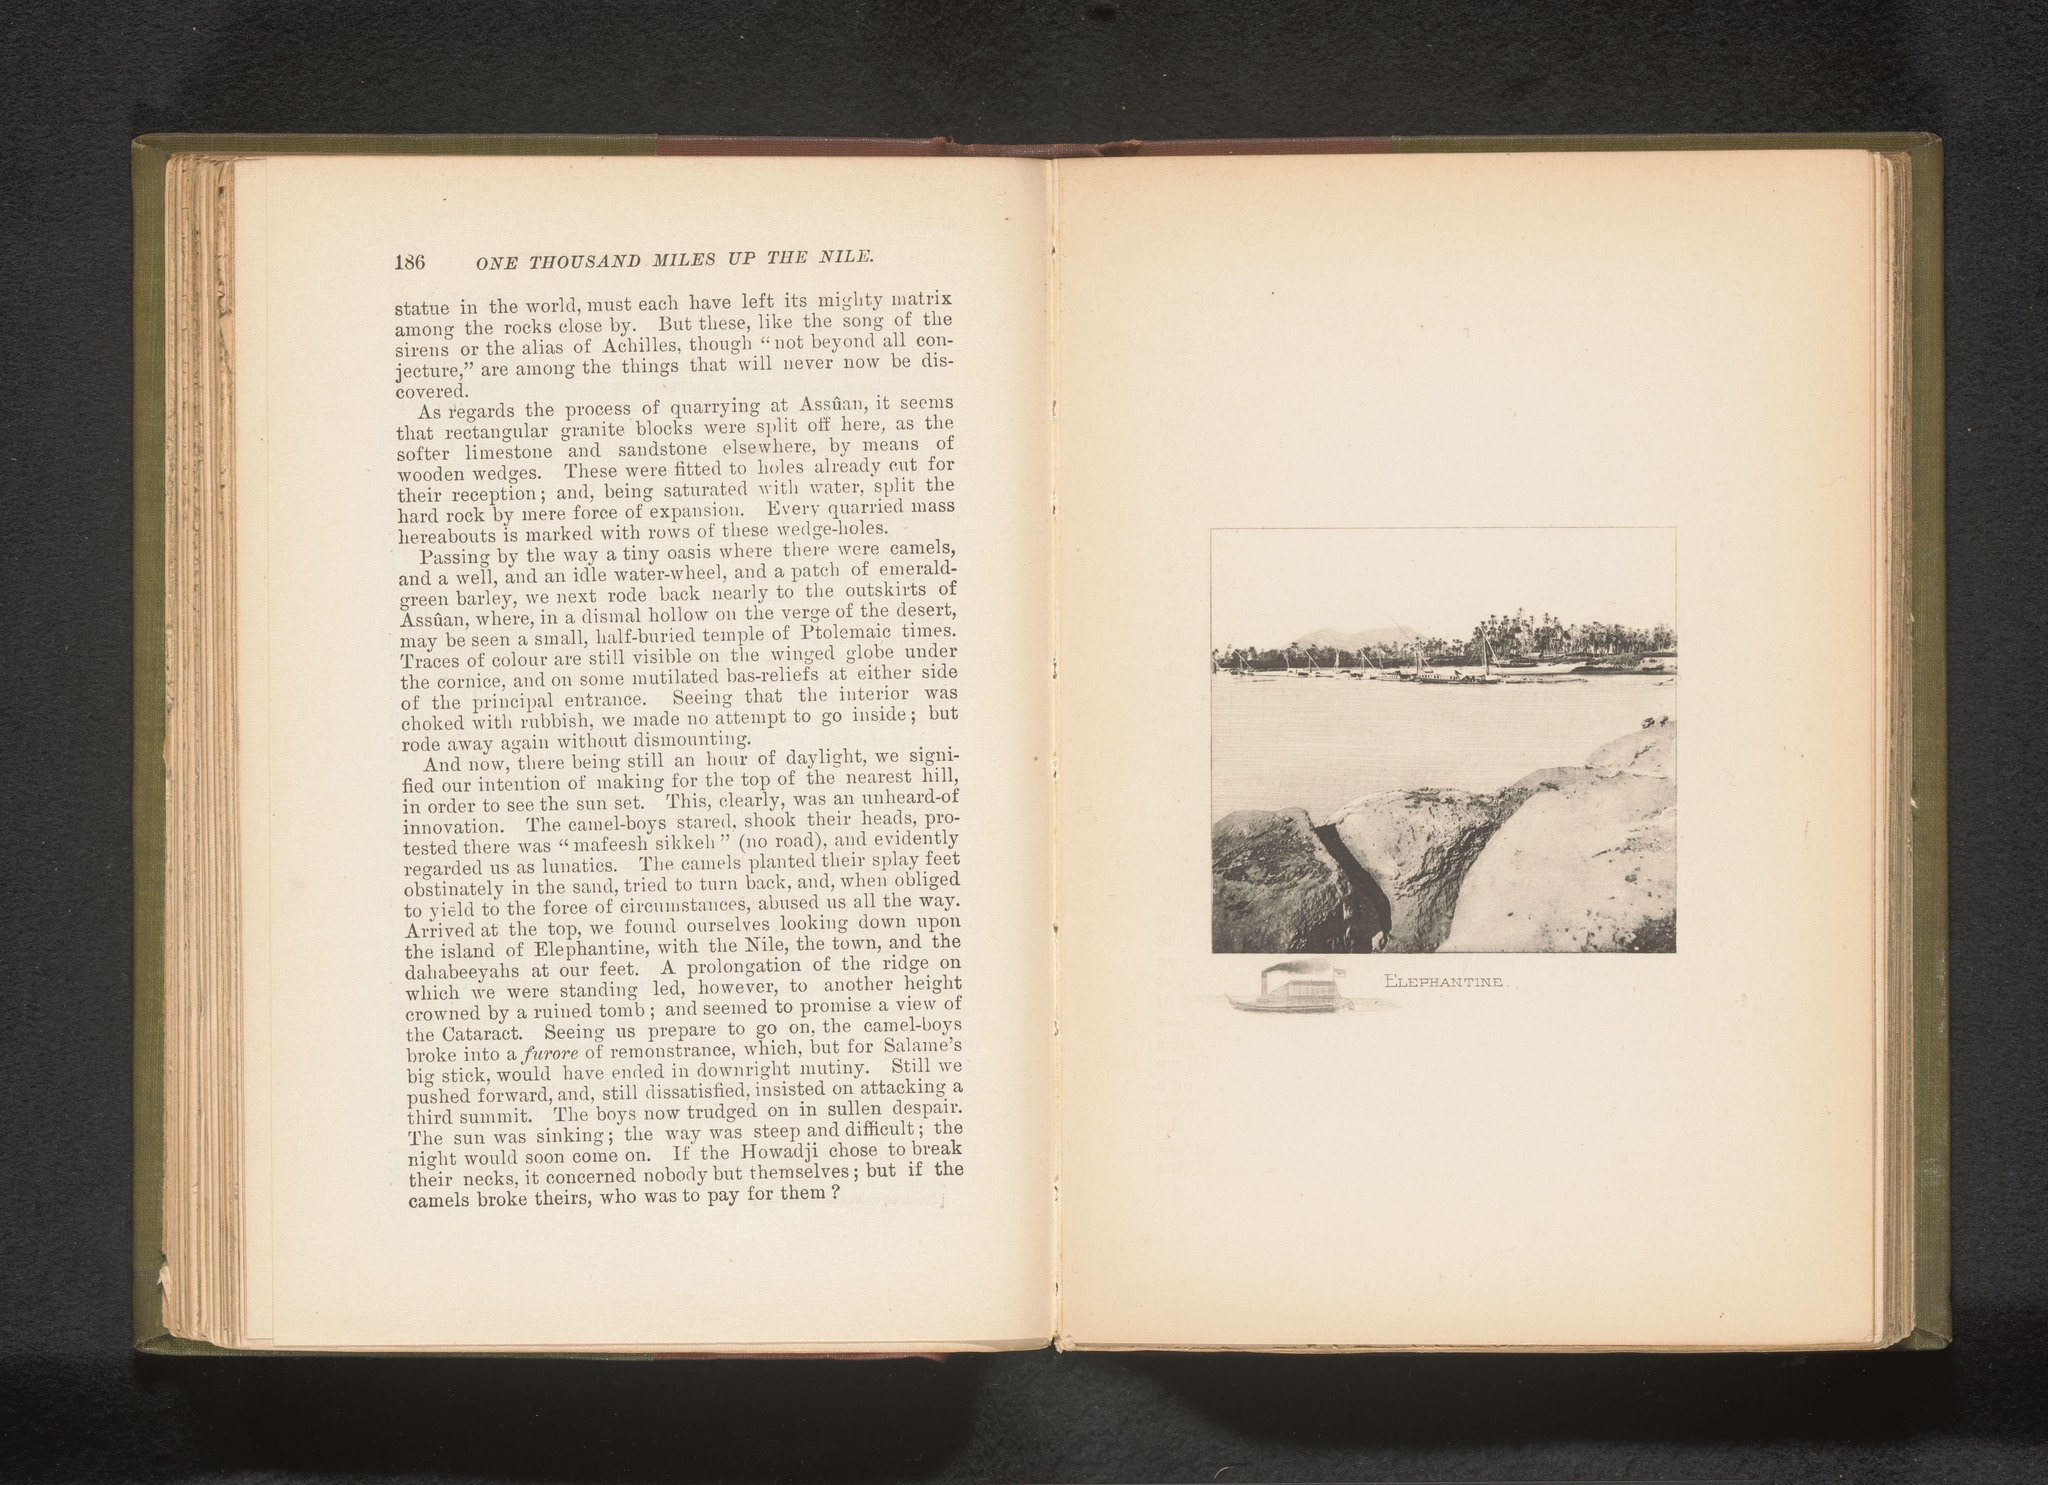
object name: page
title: Elephantine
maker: Anonymous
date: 1884-1894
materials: paper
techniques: photoaquatint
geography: aswan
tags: island, river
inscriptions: annotation